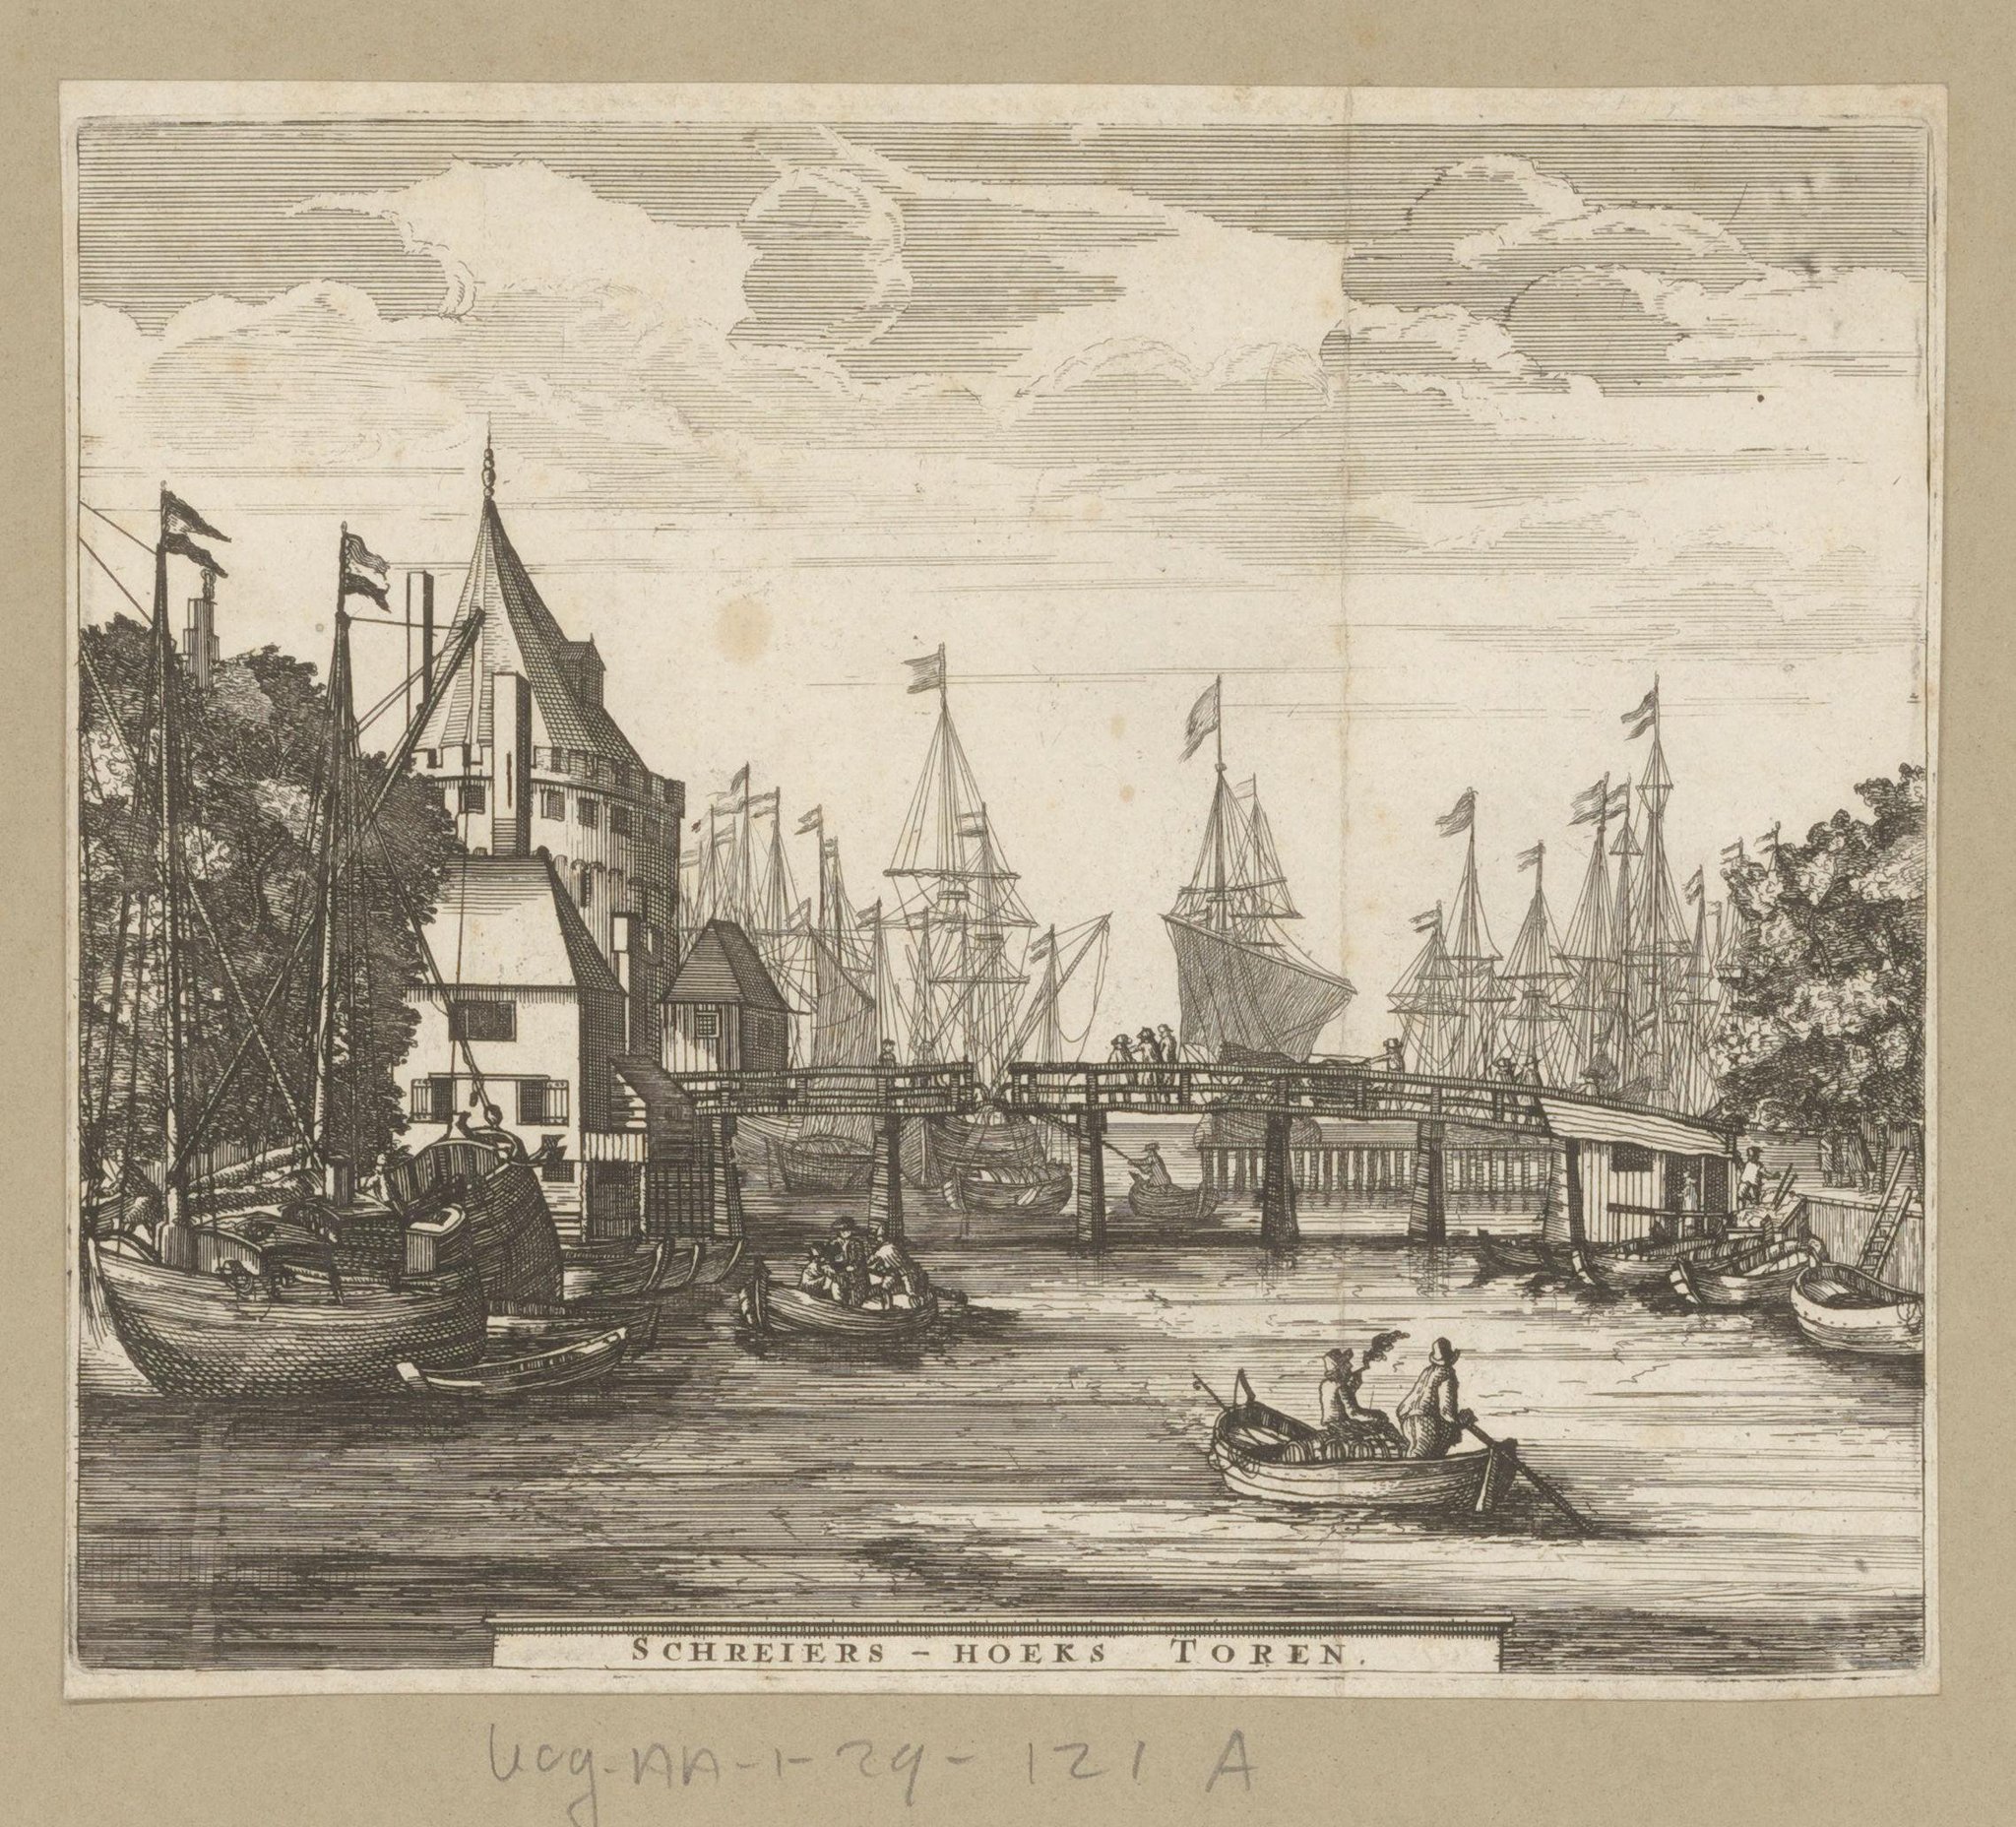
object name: print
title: Schreiers-Hoeks Toren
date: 1781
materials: paper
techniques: engraving, etching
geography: amsterdam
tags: bridge in city across river, canal, etc. (+ city(-scape) with figures, staffage), sailing-ship, sailing-boat, towers ~ fortified city, rowing-boat, canoe, etc.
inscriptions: collector's mark: Lugt 1641b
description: Prent mogelijk uit: Kok, Jacobus. Amsteldamsche jaarboeken, behelzende de merkwaardigste geschiedenissen (...). Amsterdam: Jan Barend Elwe, 1781, dl. 1.